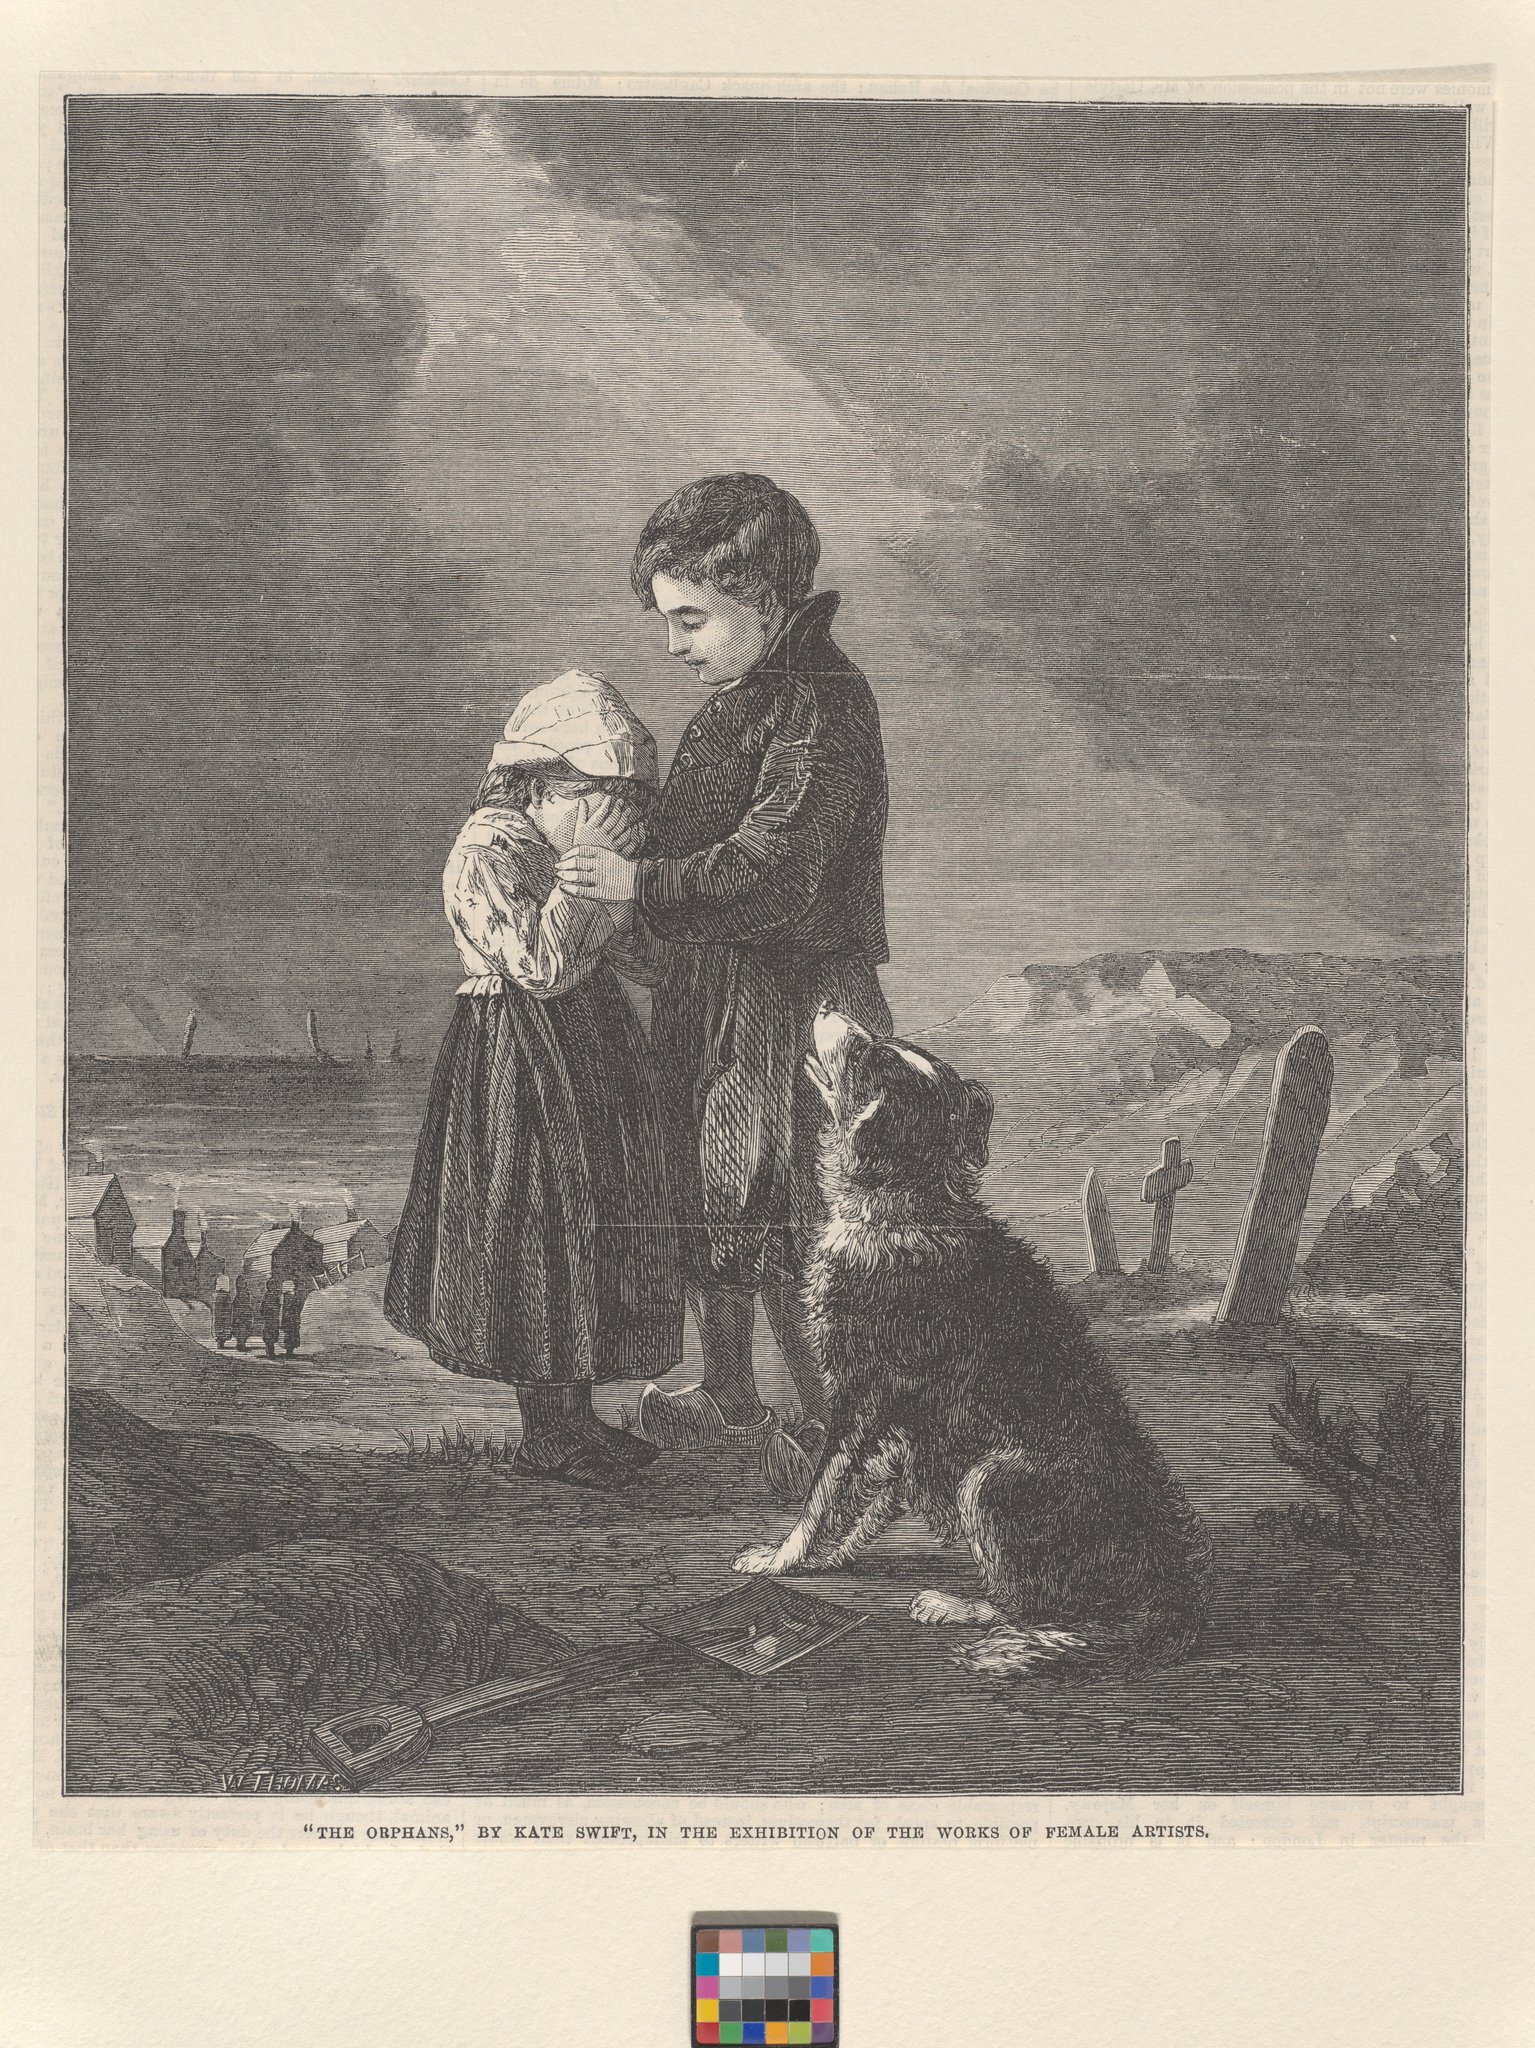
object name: print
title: The Orphans, from "Illustrated London News"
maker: william luson thomas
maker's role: engraver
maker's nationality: british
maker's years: 1830-1900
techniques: engraving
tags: sadness,boys,girls,dogs